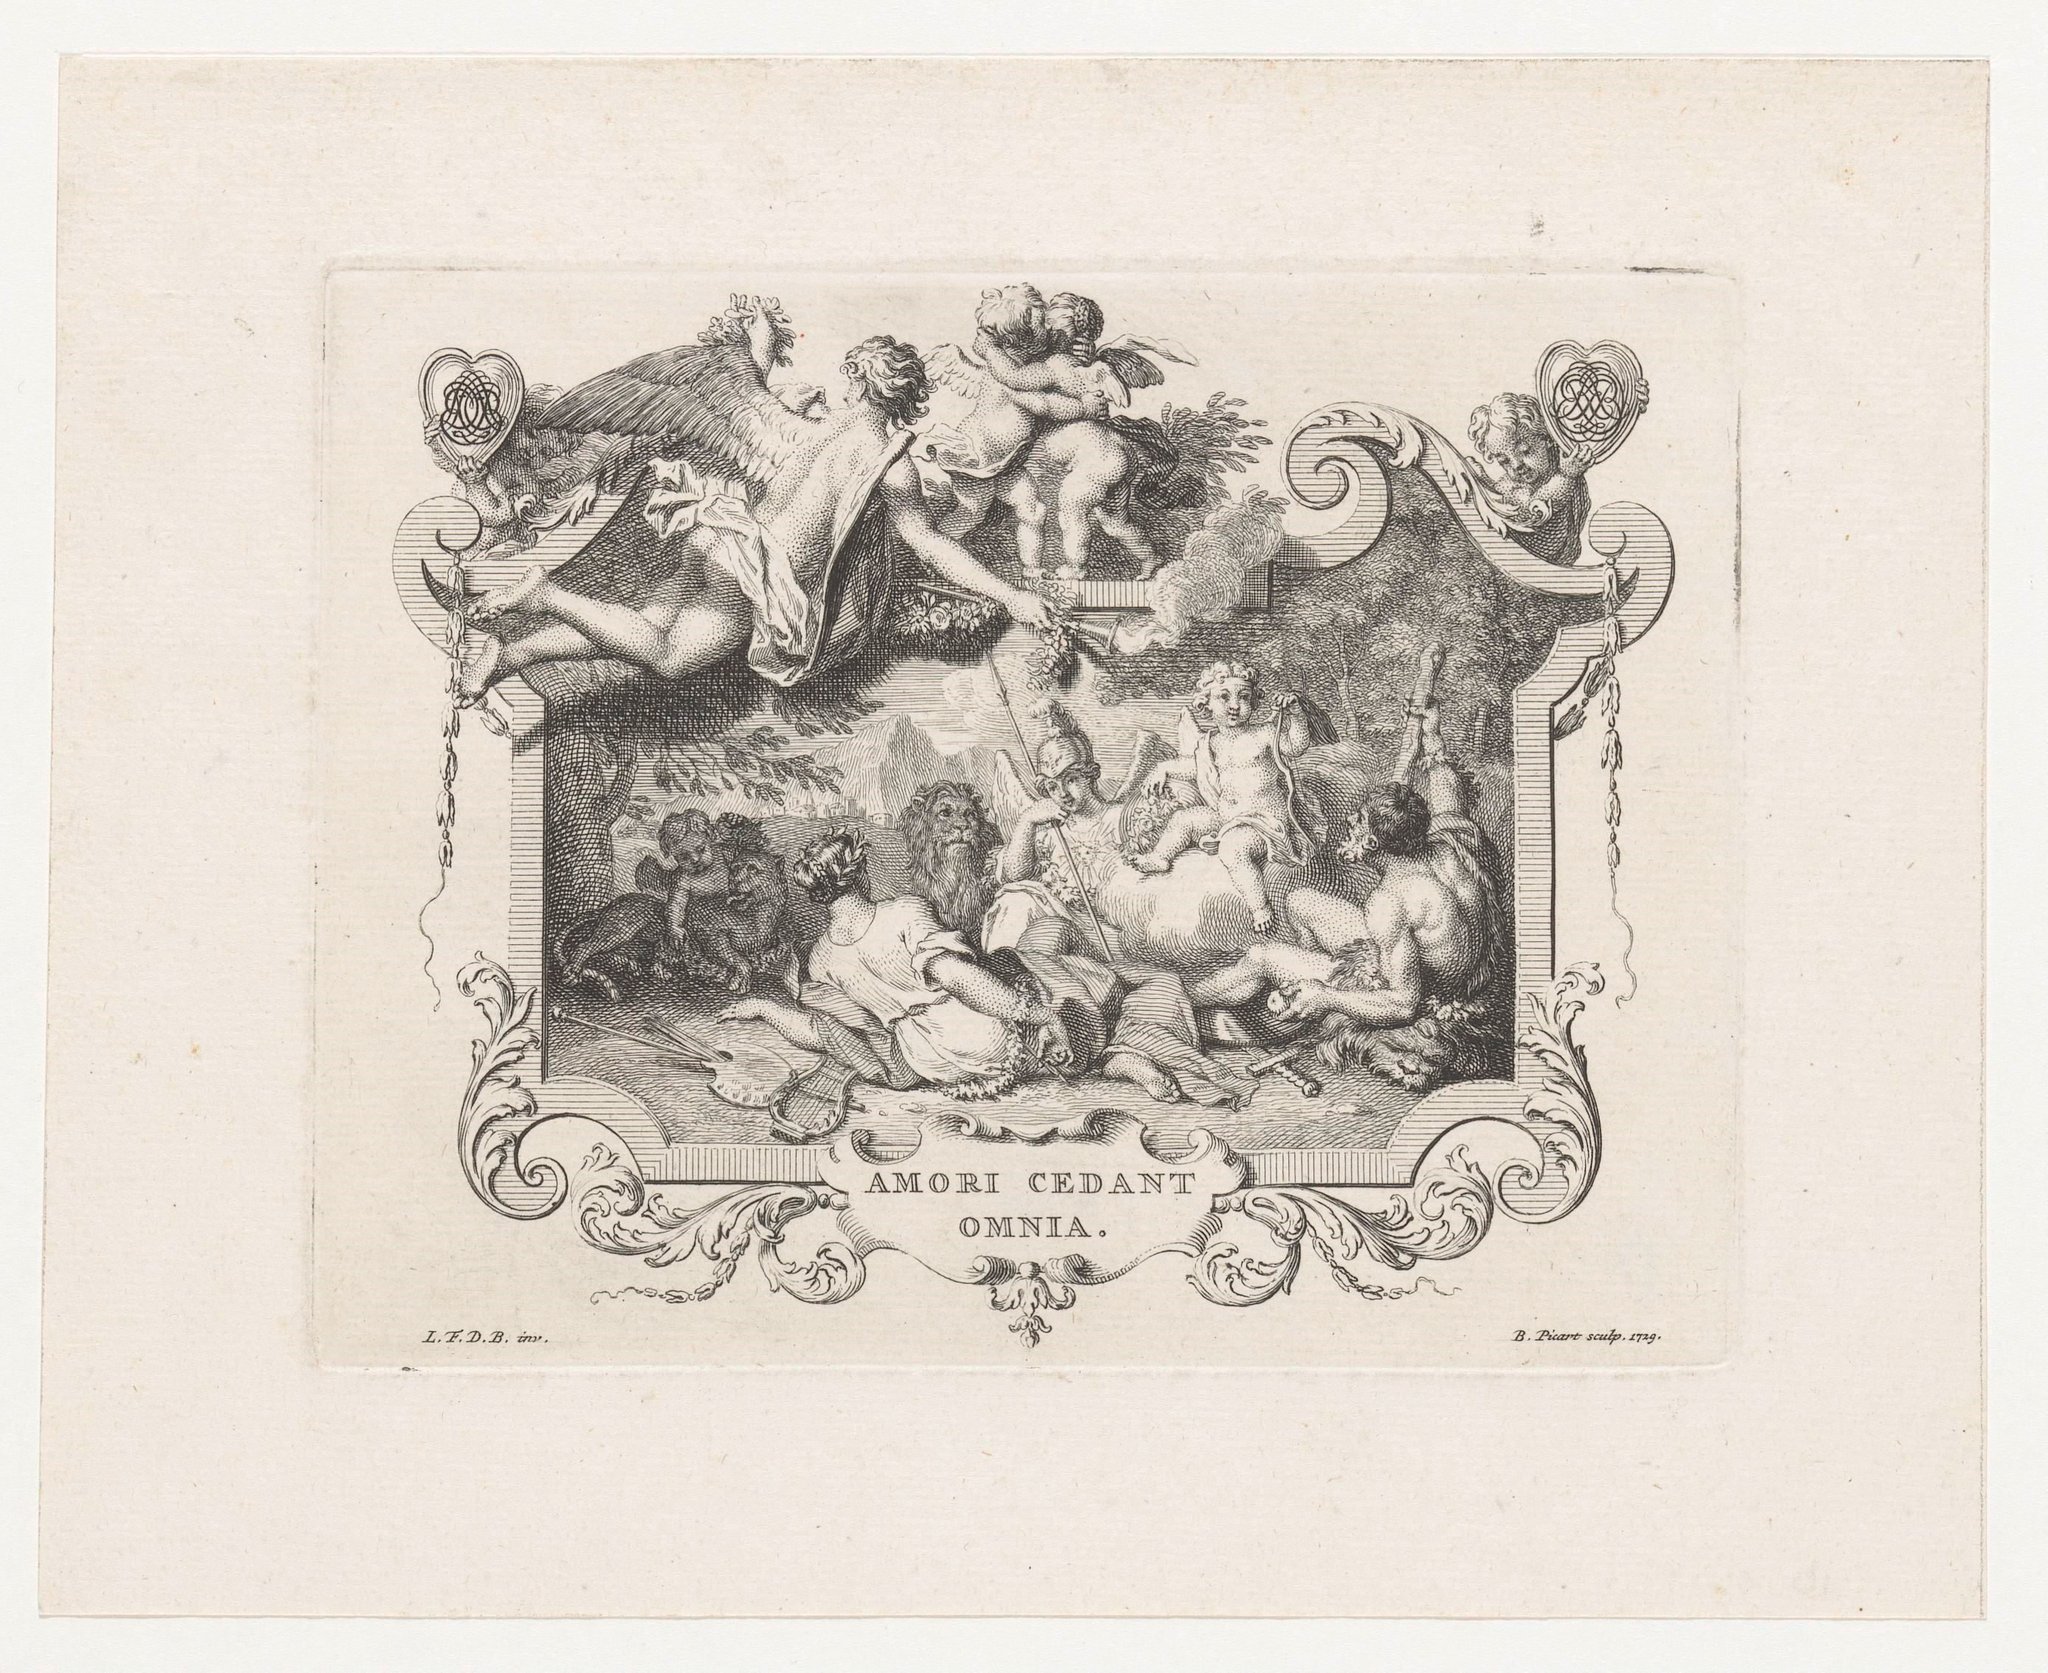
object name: print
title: Allegorische voorstelling ter gelegenheid van het huwelijk van Louis Fabricius Dubourg en zijn vrouw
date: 1729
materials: paper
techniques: engraving, etching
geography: amsterdam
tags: (story of) hercules (heracles), (story of) hymen(aeus), 'pictura', symbolic representations, allegories and emblems ~ painting; 'pittura' (ripa), (story of) minerva (pallas, athena), marriage, married couple, 'matrimonium', (story of) cupid, amor (eros)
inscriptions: collector's mark: Lugt 2228, inscription: ‘[A]P 315’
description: Allegorische voorstelling ter gelegenheid van het huwelijk van Louis Fabricius Dubourg en zijn vrouw te Amsterdam in 1729. Amor zit als de liefde die alles overwint op een wolk met de globe onder zijn arm. Bij hem zitten Hercules, Minerva als beschermster van de wetenschap en de Schilderkunst. Links een leeuw en een tijger. De voorstelling is gevat in een ornamentele lijst met rechts boven de huwelijksgod Hymen en putti, die elkaar omhelzen. Midden onder het devies: Amori Cedant Omnia.